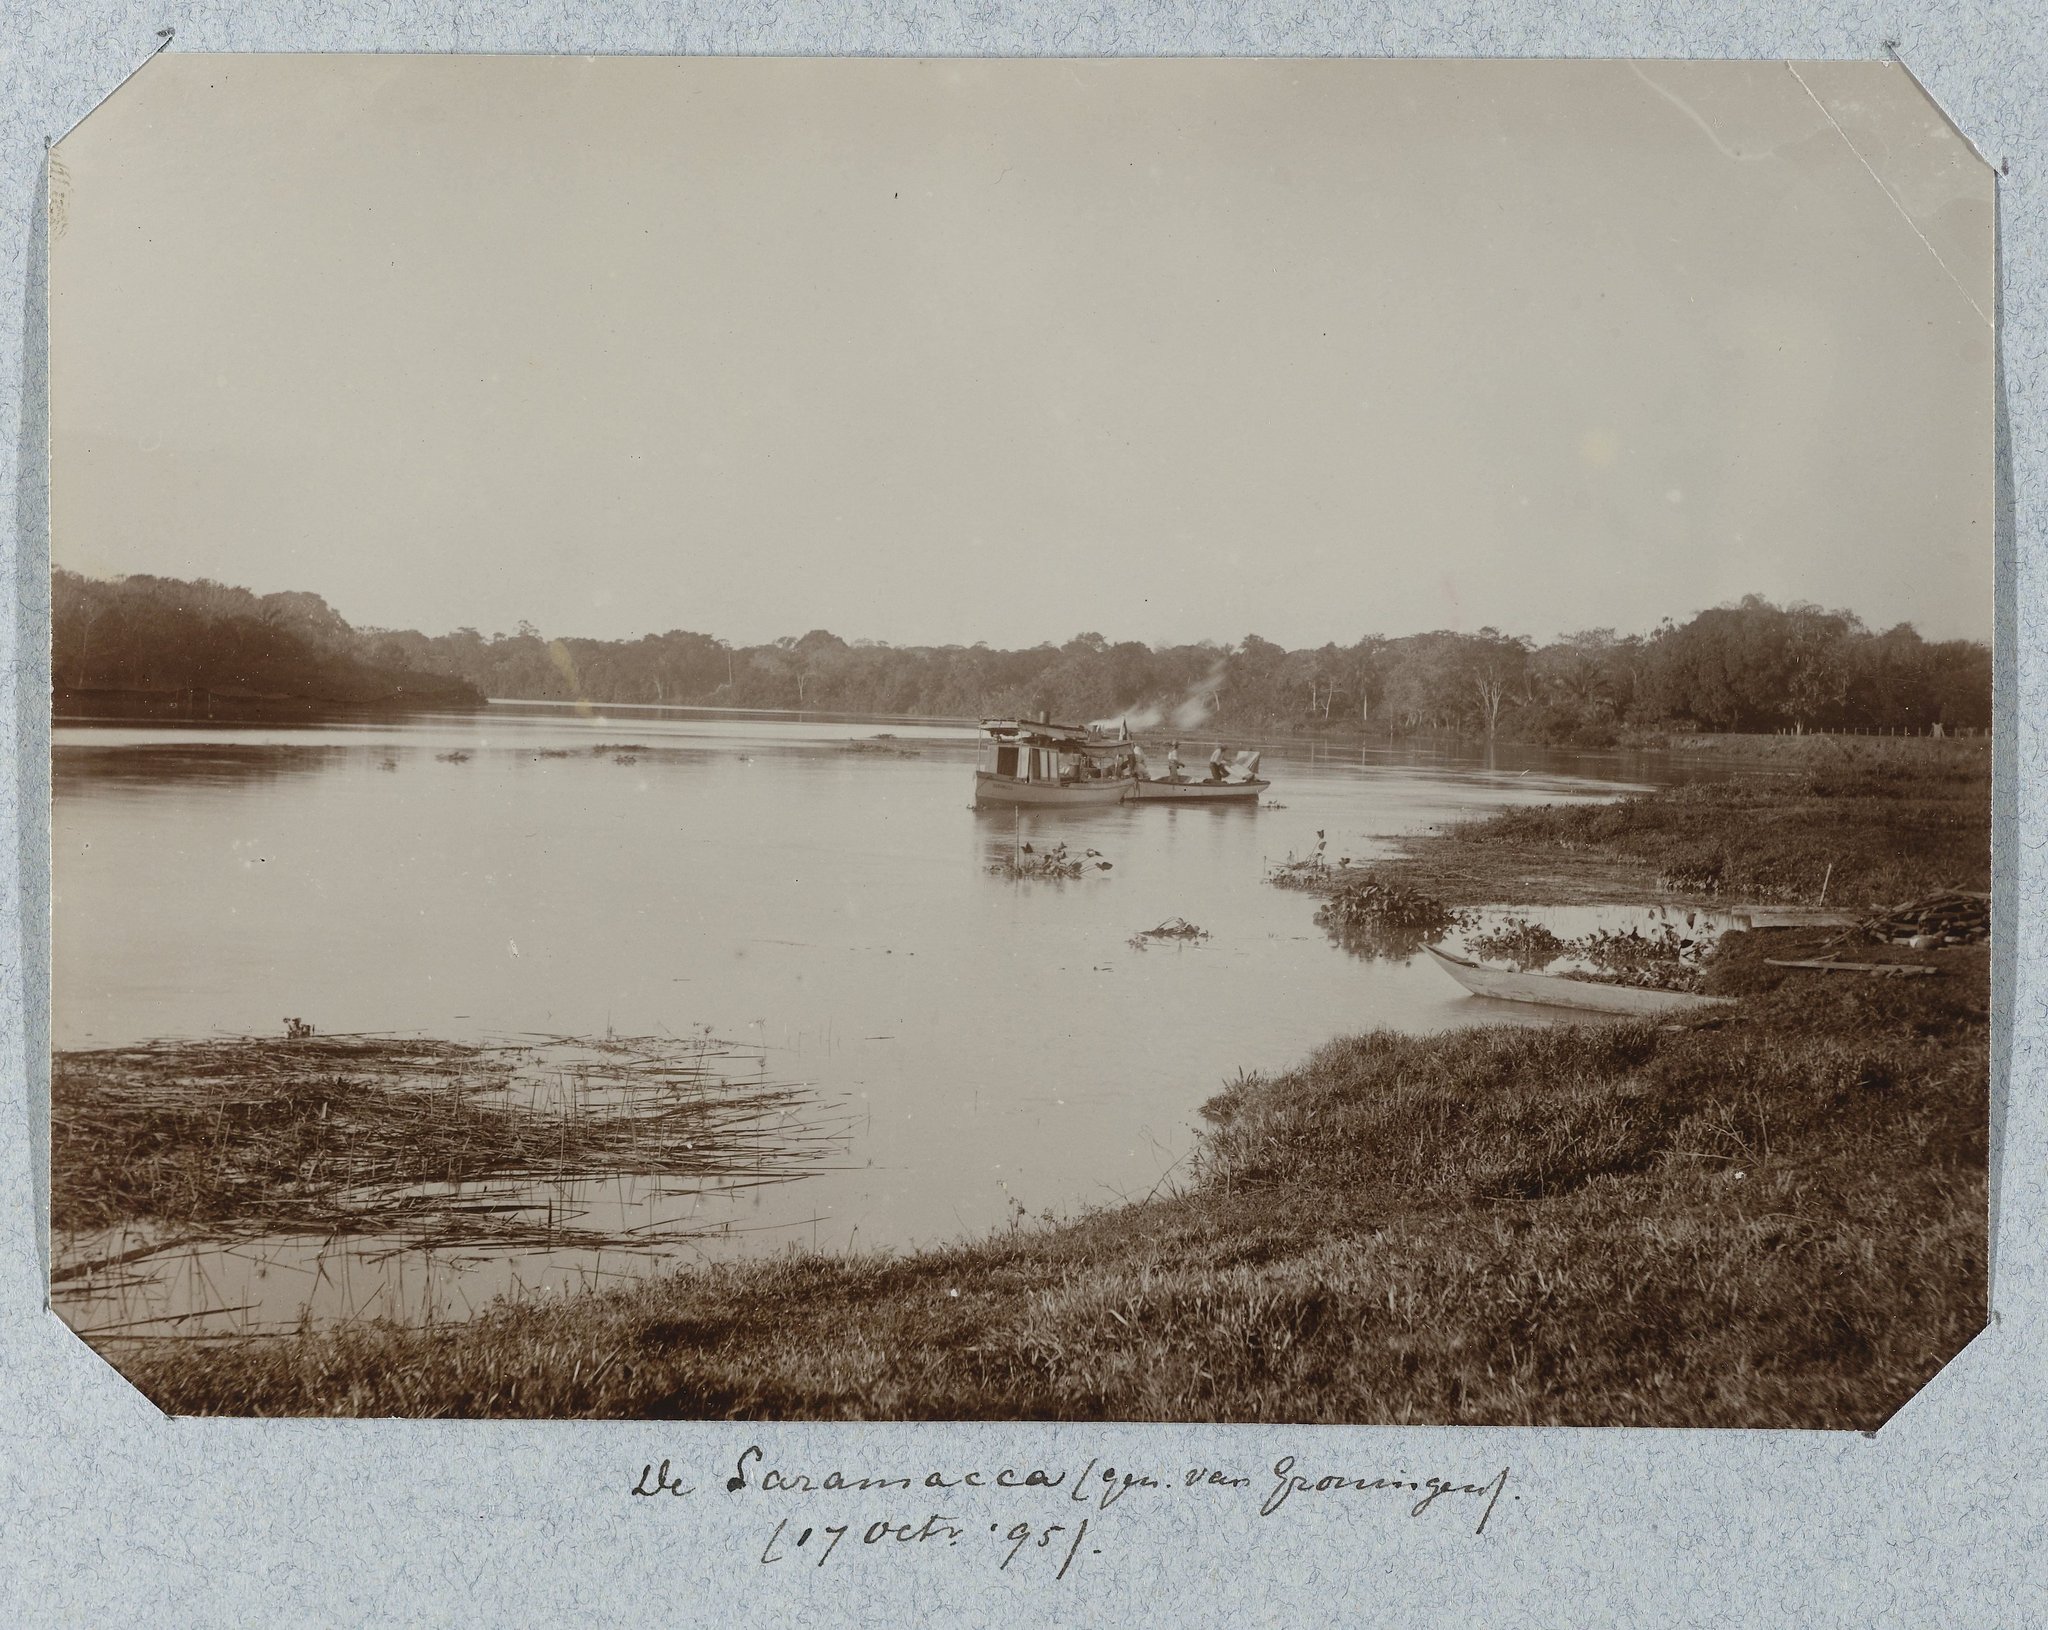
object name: photograph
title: De Saramacca (gen. van Groningen). (17 octr. '95)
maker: théodore van lelyveld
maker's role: painter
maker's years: 1867-1954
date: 1895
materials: photographic support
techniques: collodion silver print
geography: suriname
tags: river (+ landscape with figures, staffage), suriname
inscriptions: inscription: ‘De Saramacca (gen. van Groningen). (17 octr. '95)’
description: Riviergezicht met een boot op de Saramacca. Fotoafdruk in een fotoalbum van Théodore van Lelyveld over Suriname uit 1895-1898.